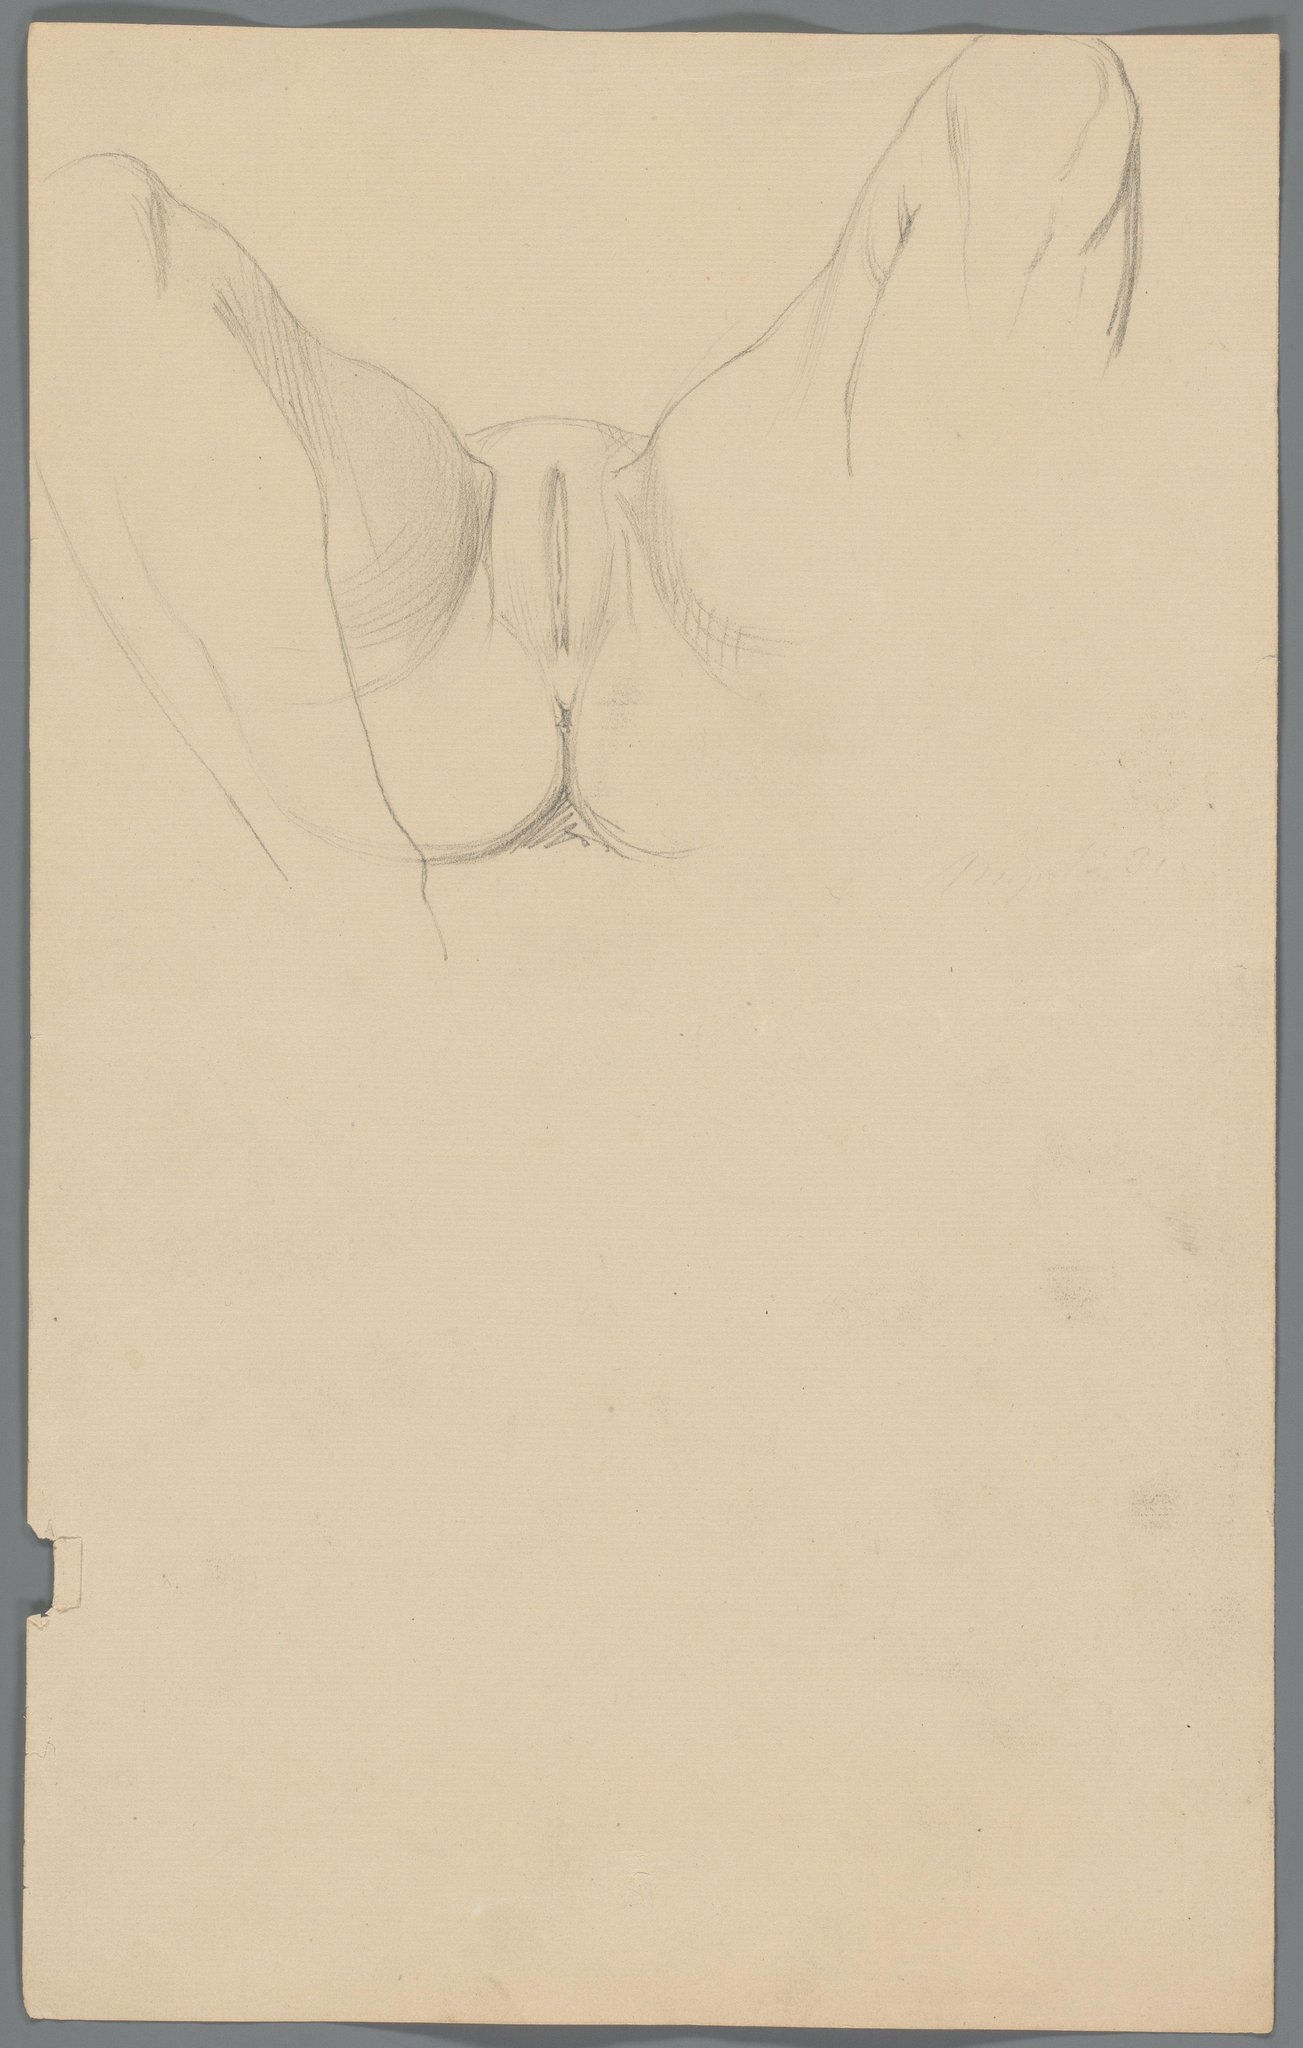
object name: drawing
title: Studie van het onderlichaam van een vrouw met opgetrokken benen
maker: jacobus everhardus josephus van den berg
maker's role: draughtsman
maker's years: 1802-1861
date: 1812-1861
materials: paper, pencil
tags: lying figure - aa - female human figure, female sexual organs